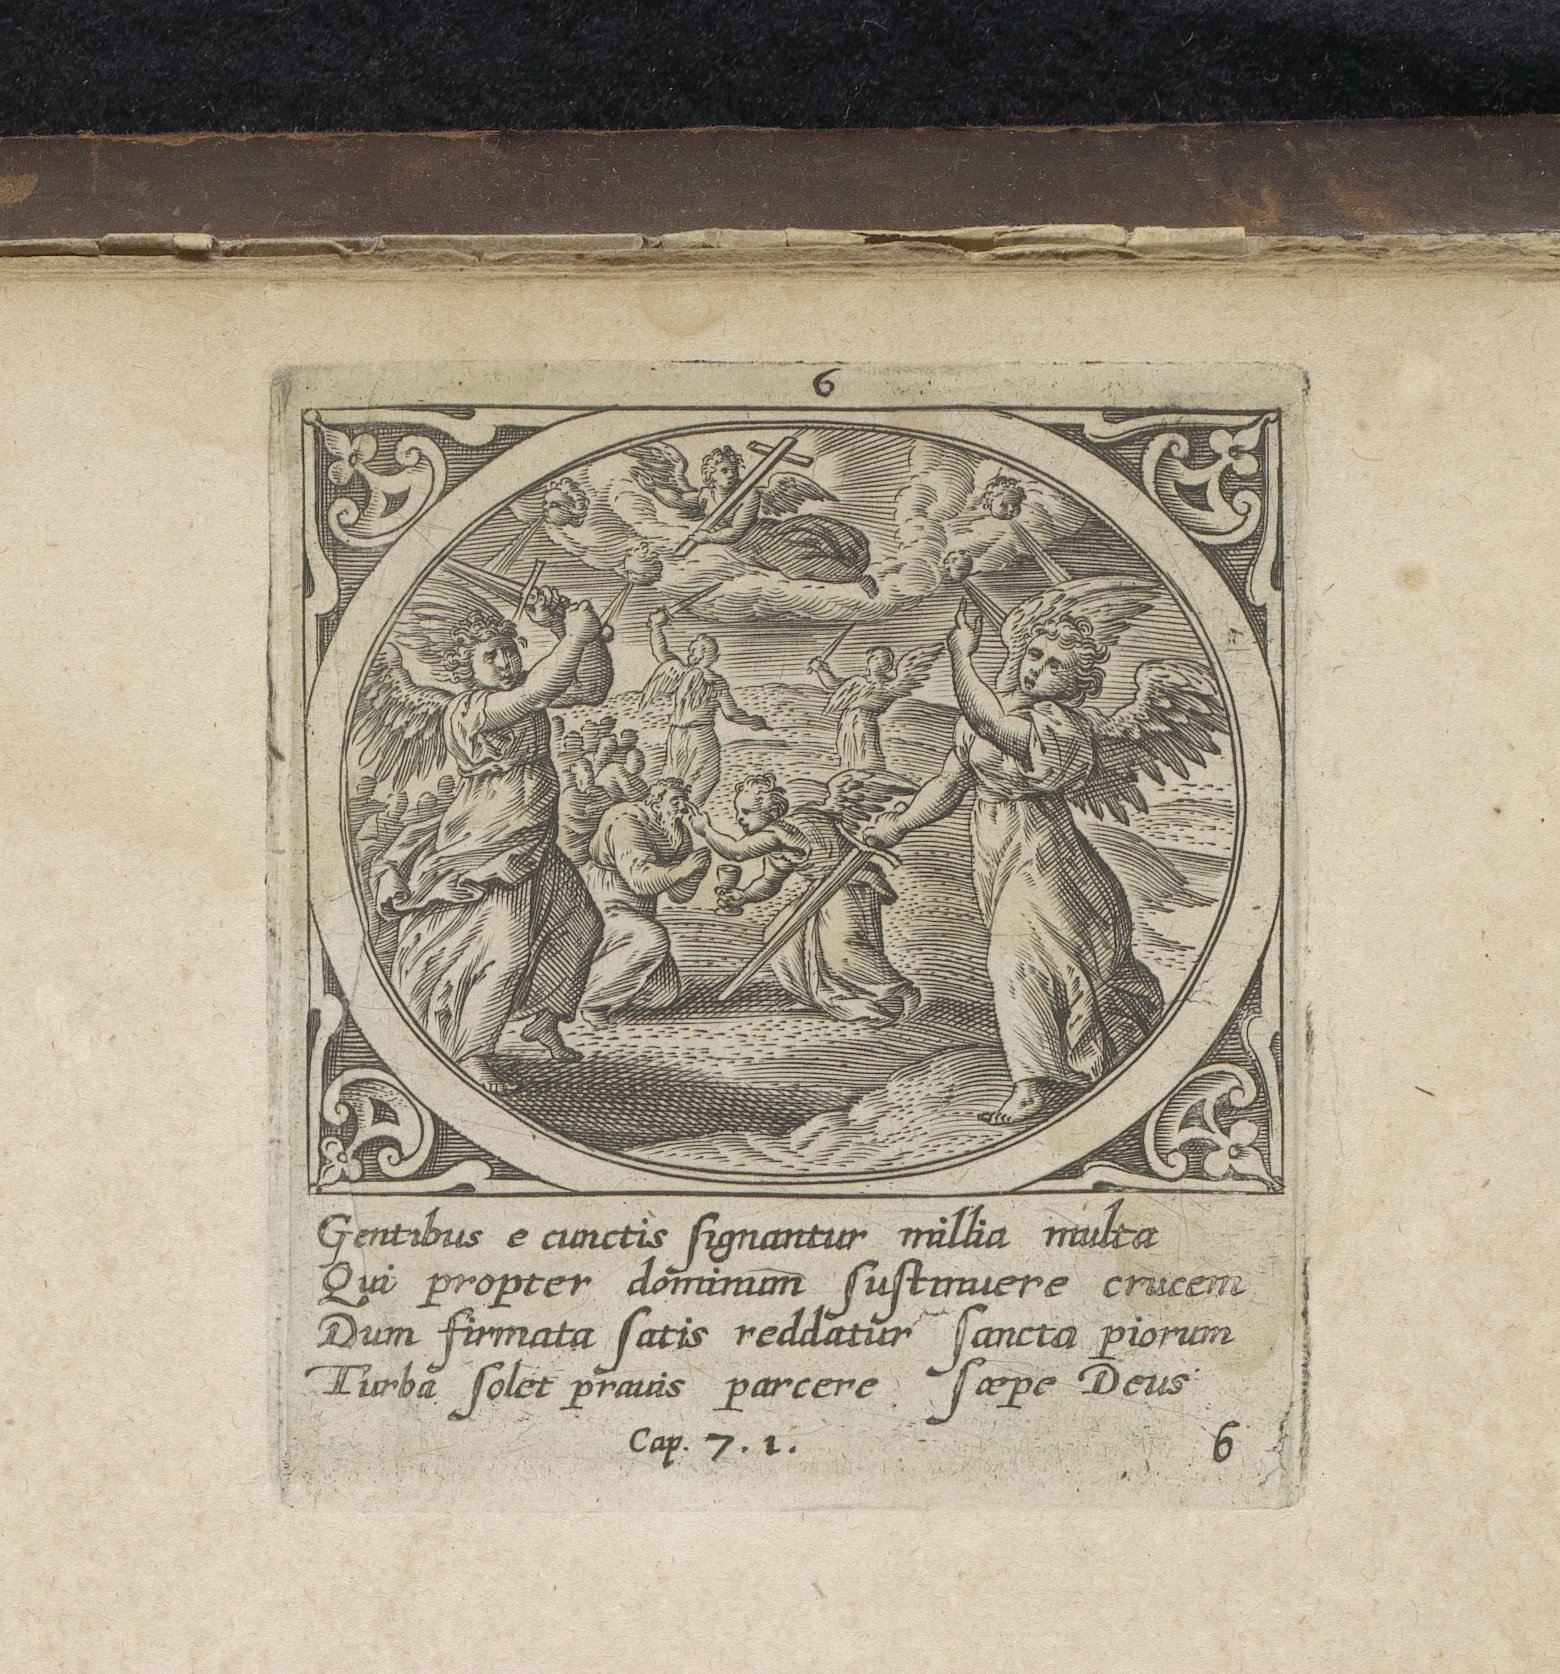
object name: album leaf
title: Openbaring van Johannes op Patmos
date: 1585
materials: paper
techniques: engraving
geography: amsterdam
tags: the four winds are restrained by four angels, sealing of the tribes of israel, the 144-thousand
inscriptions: number: ‘20[8]’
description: Vier engelen houden met hun zwaard de vier winden in bedwang. In het midden brengt een engel het zegel van God aan op het voorhoofd van een lid van een stam van Israël. Boven in de wolken een engel met een kruis. Onder de voorstelling een verwijzing in het Latijn naar de Bijbeltekst in Op. 7. Deze prent maakt deel uit van een album.